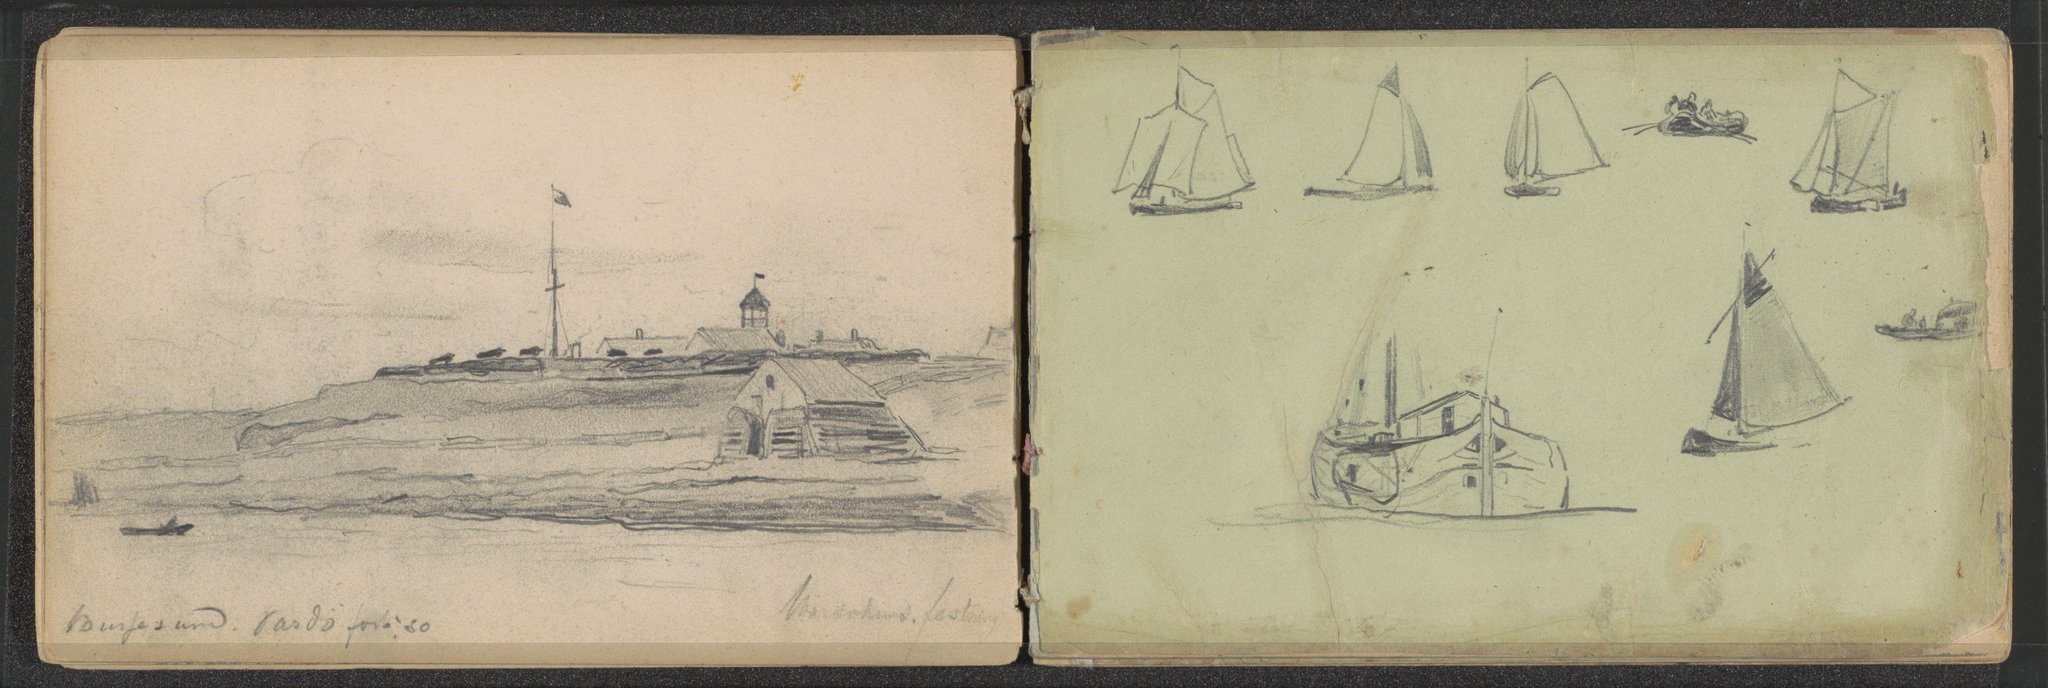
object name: sketchbook leaf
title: Gezicht op Vardø met de vesting Vardøhus aan Bussesundet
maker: louis apol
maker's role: draughtsman, painter, print maker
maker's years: 1850-1936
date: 1880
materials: paper, pencil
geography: vardø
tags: fortress, coast (in polar regions)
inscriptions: annotation: ‘Bussesund. Vardö fort [...]/ Vardöhus, festning’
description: Blad 14 verso uit een schetsboek met 35 bladen betekend tijdens de expeditie naar Nova Zembla in 1880.